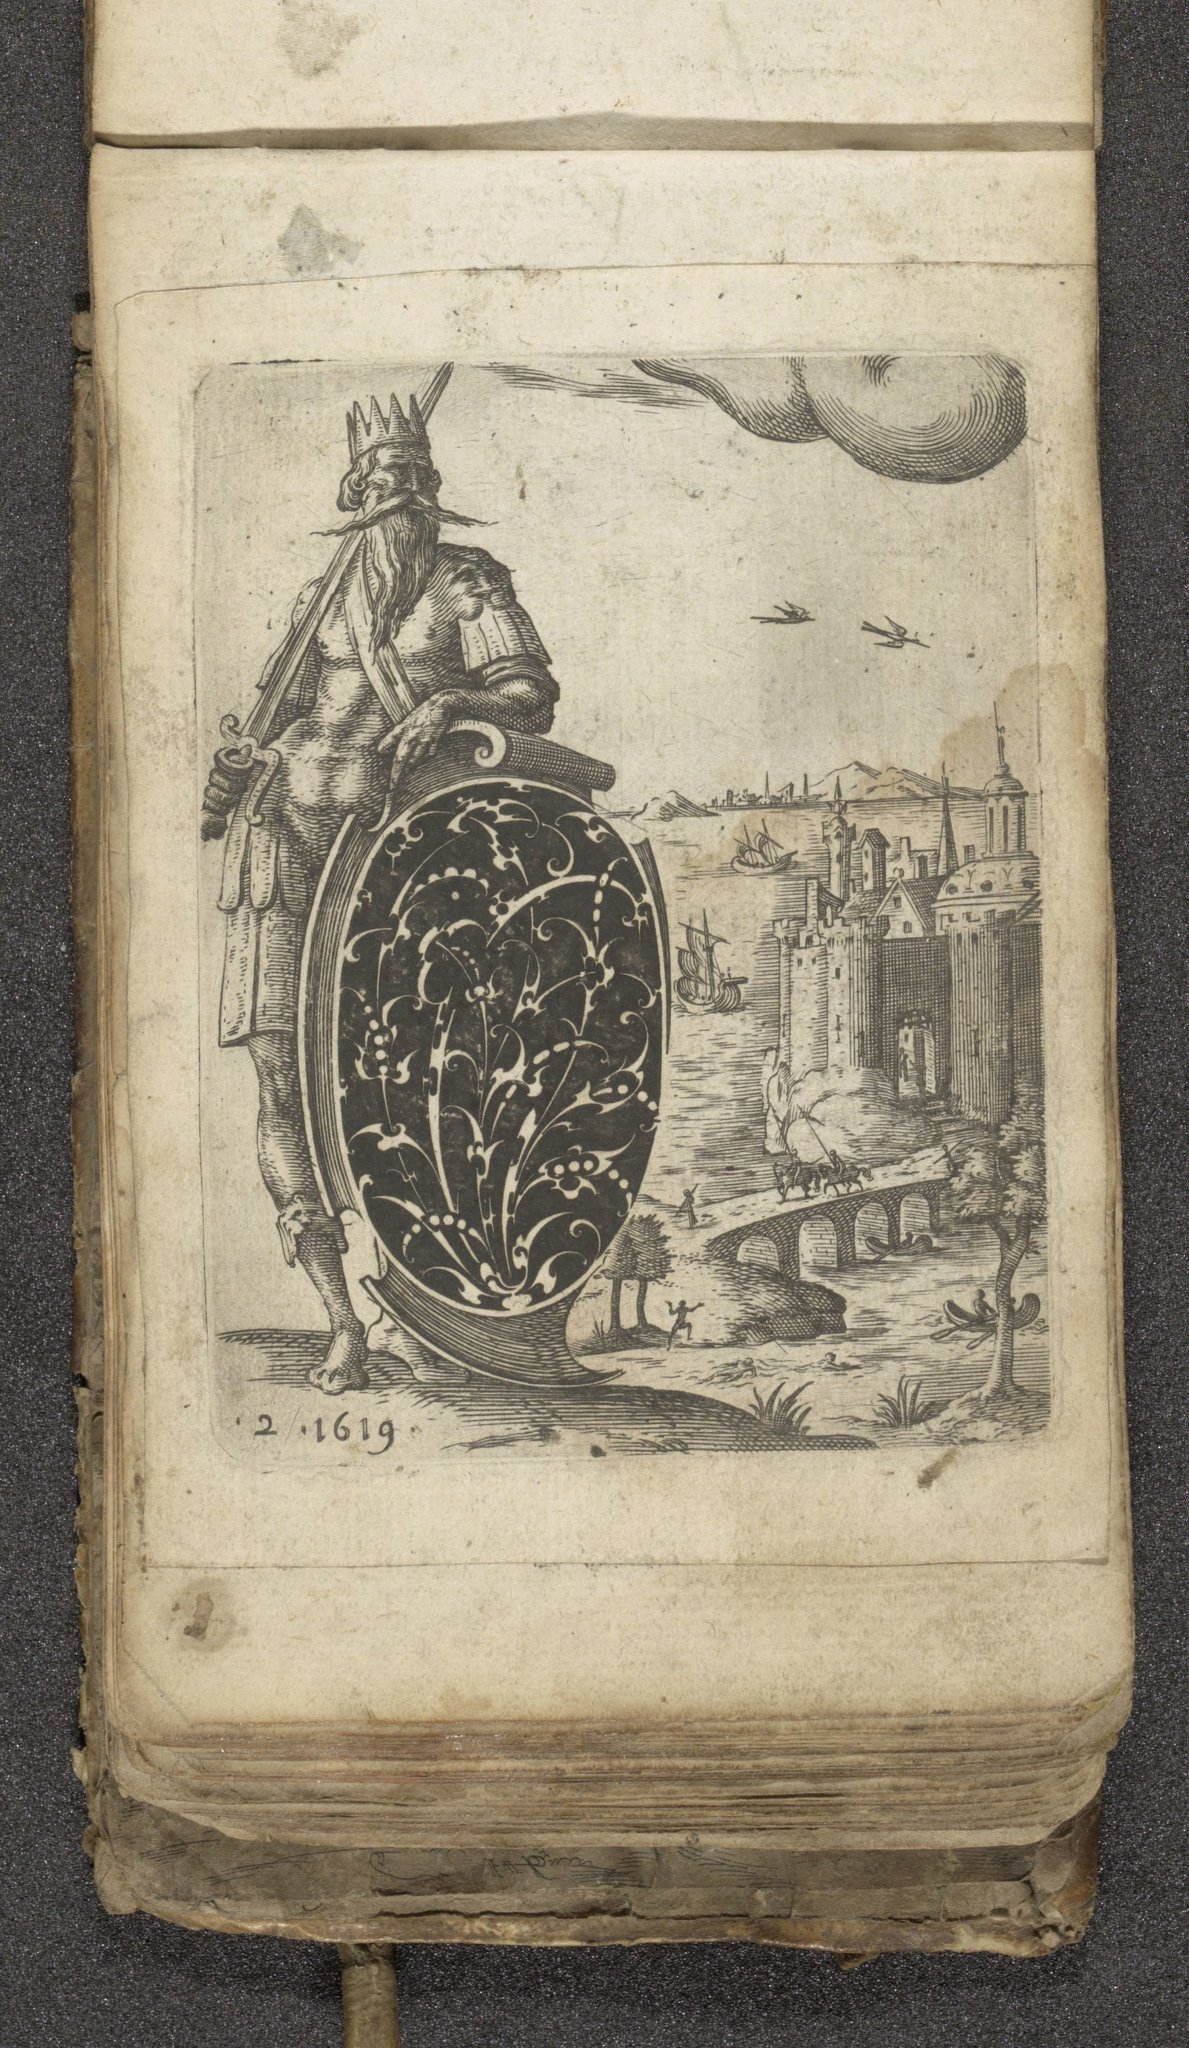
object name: ornament print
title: Zwartornamenten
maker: jean toutin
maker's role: print maker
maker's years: 1578-1644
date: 1619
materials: paper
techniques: engraving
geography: châteaudun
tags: protective weapons: shield, ornaments ~ art, castle, king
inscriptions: inscription: ‘63’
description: Zwartornament in de vorm van een schild, vastgehouden door een geharnaste koning met zwaard. Rechts een kasteel, gelegen aan de zee. Linksonder genummerd 2. De prent maakt deel uit van een album.